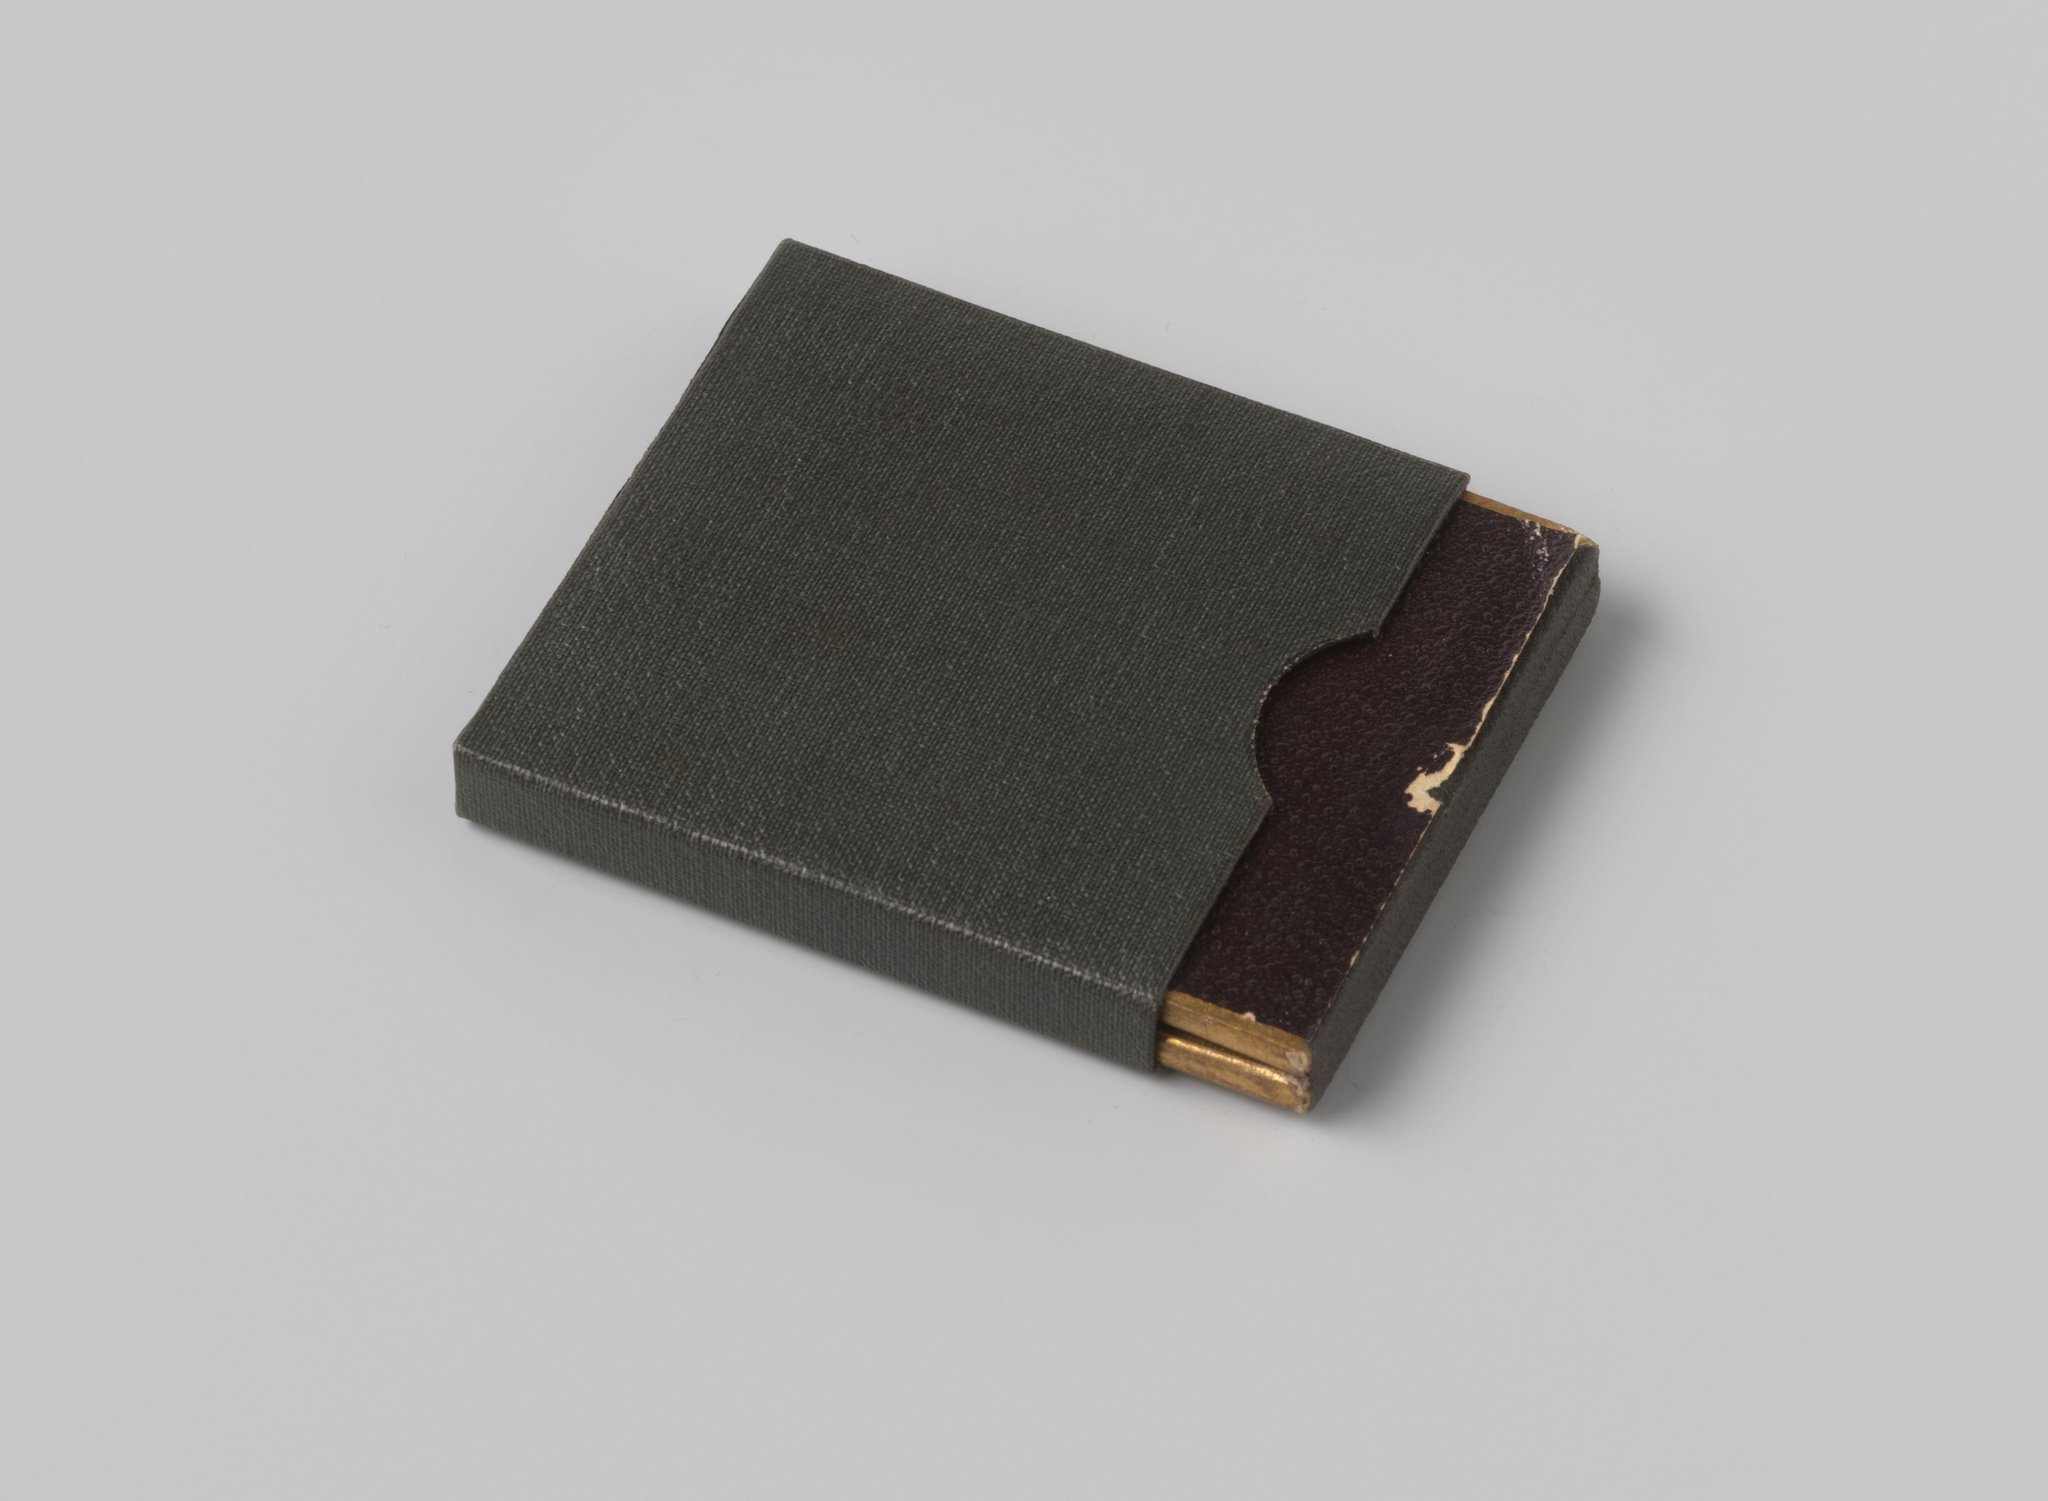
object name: medal box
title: Penningdoos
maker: Anonymous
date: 1885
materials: leather, paper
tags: amsterdam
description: Cassette met aan de binnenzijde paars fluweel, buitenzijde bruin leer met verguld randje omplakt. Daaromheen een hoesje van karton met bruin linnen beplakt. Met bijbehorende penning NG-2000-1-1.